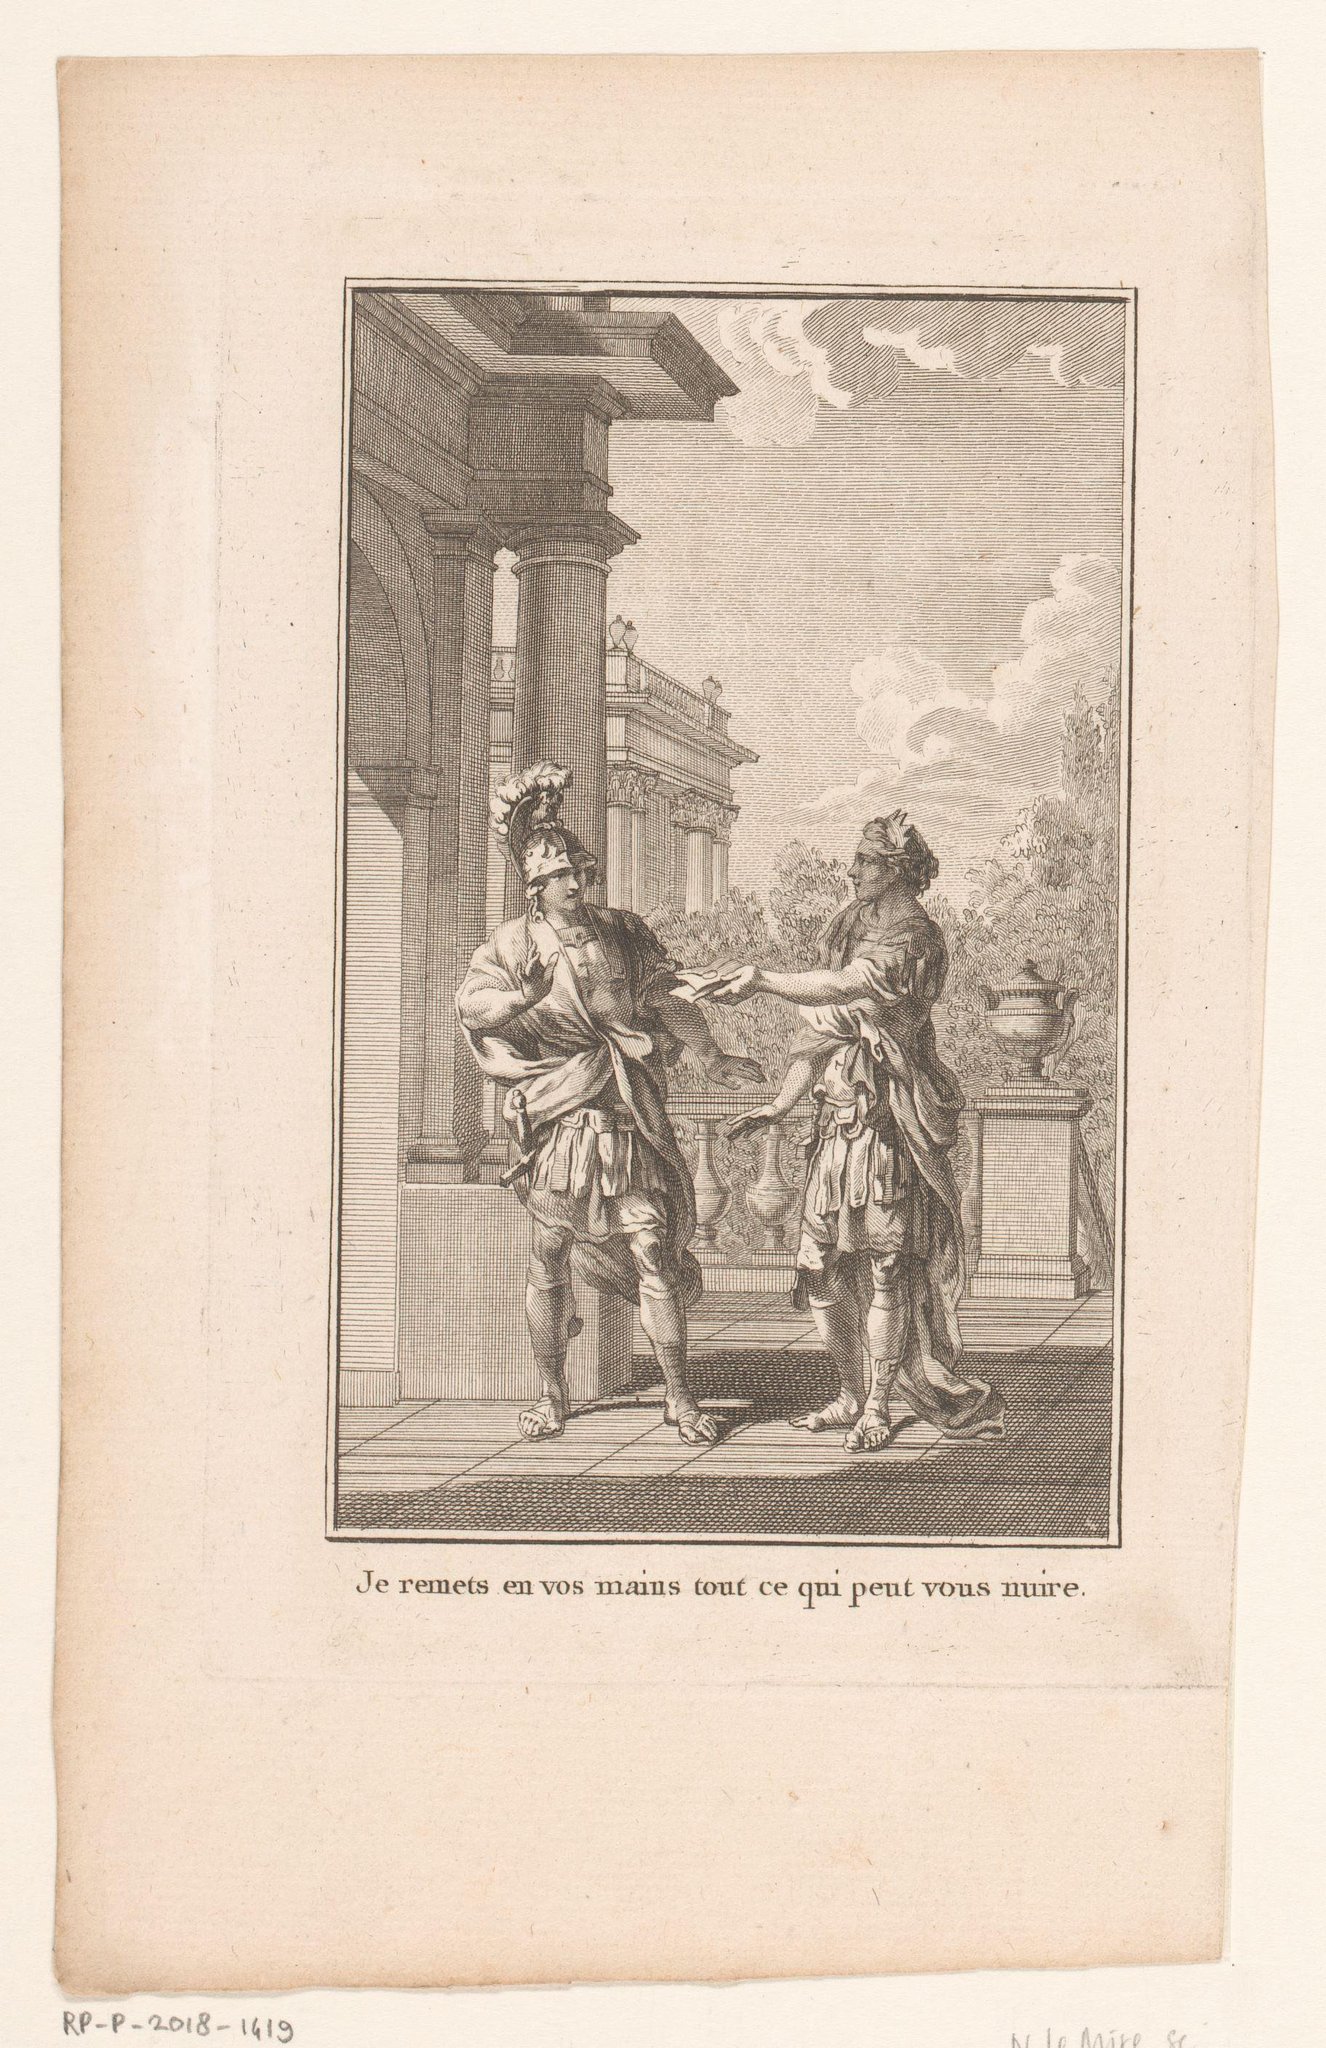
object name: book illustration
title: Scène uit Agésilas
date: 1763-1764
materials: paper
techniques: engraving, etching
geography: geneva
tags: theatre, theatrical performance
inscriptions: collector's mark: Lugt 2228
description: Prent uit: Corneille, Pierre. Théâtre (...). Genève: Cramer, 1764. Dit betreft een illustratie op p. 263 uit deel 8, getiteld 'Agésilas'.